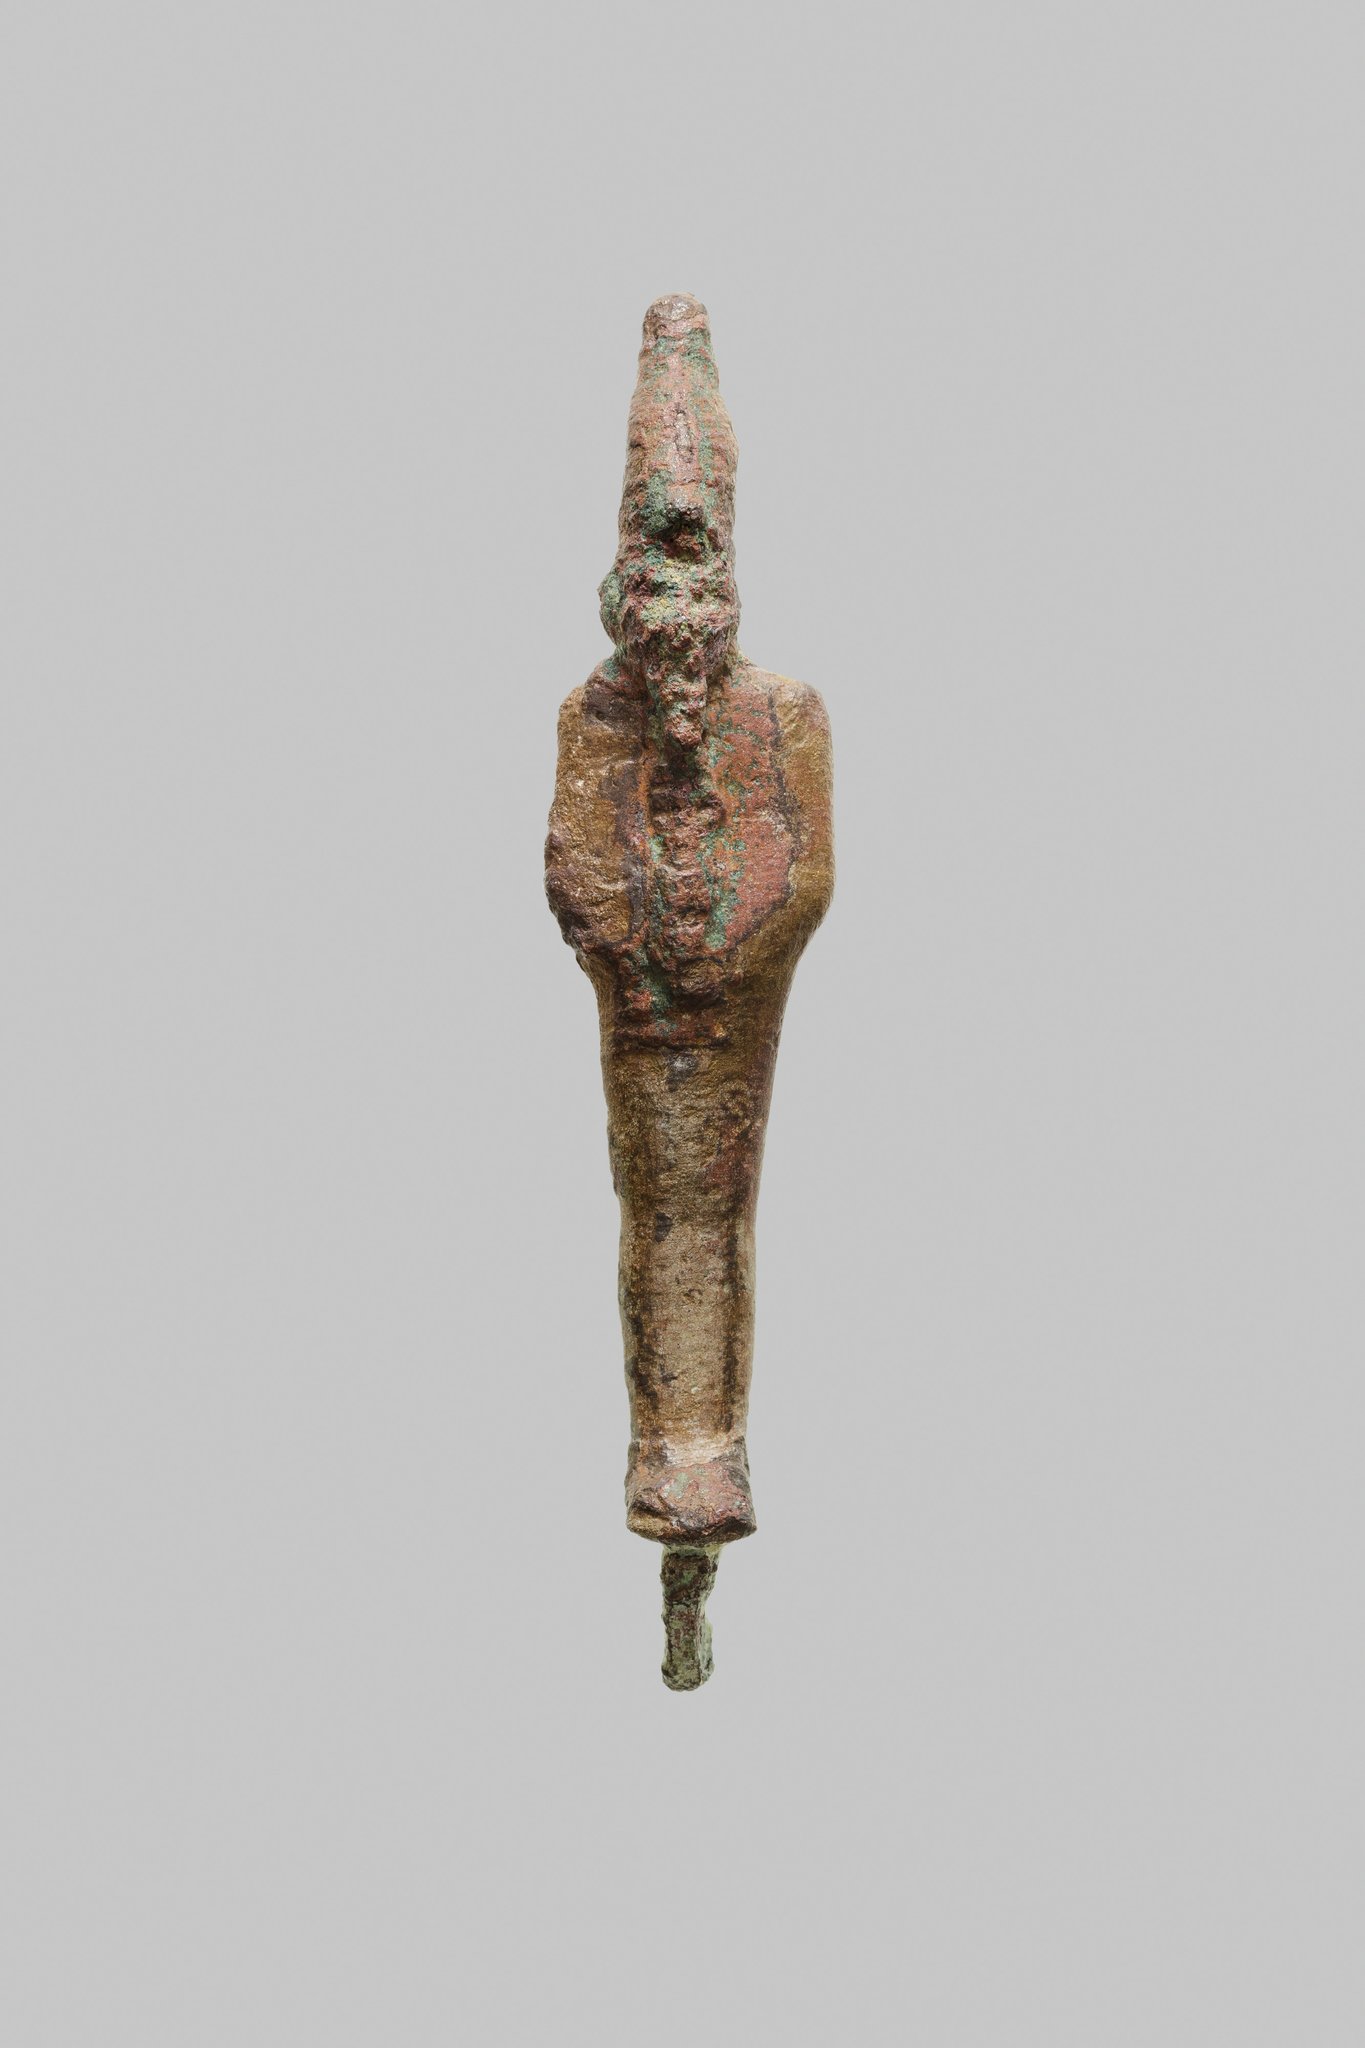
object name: statuette, osiris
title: Statuette of Osiris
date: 712-30 BCE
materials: bronze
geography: egypt